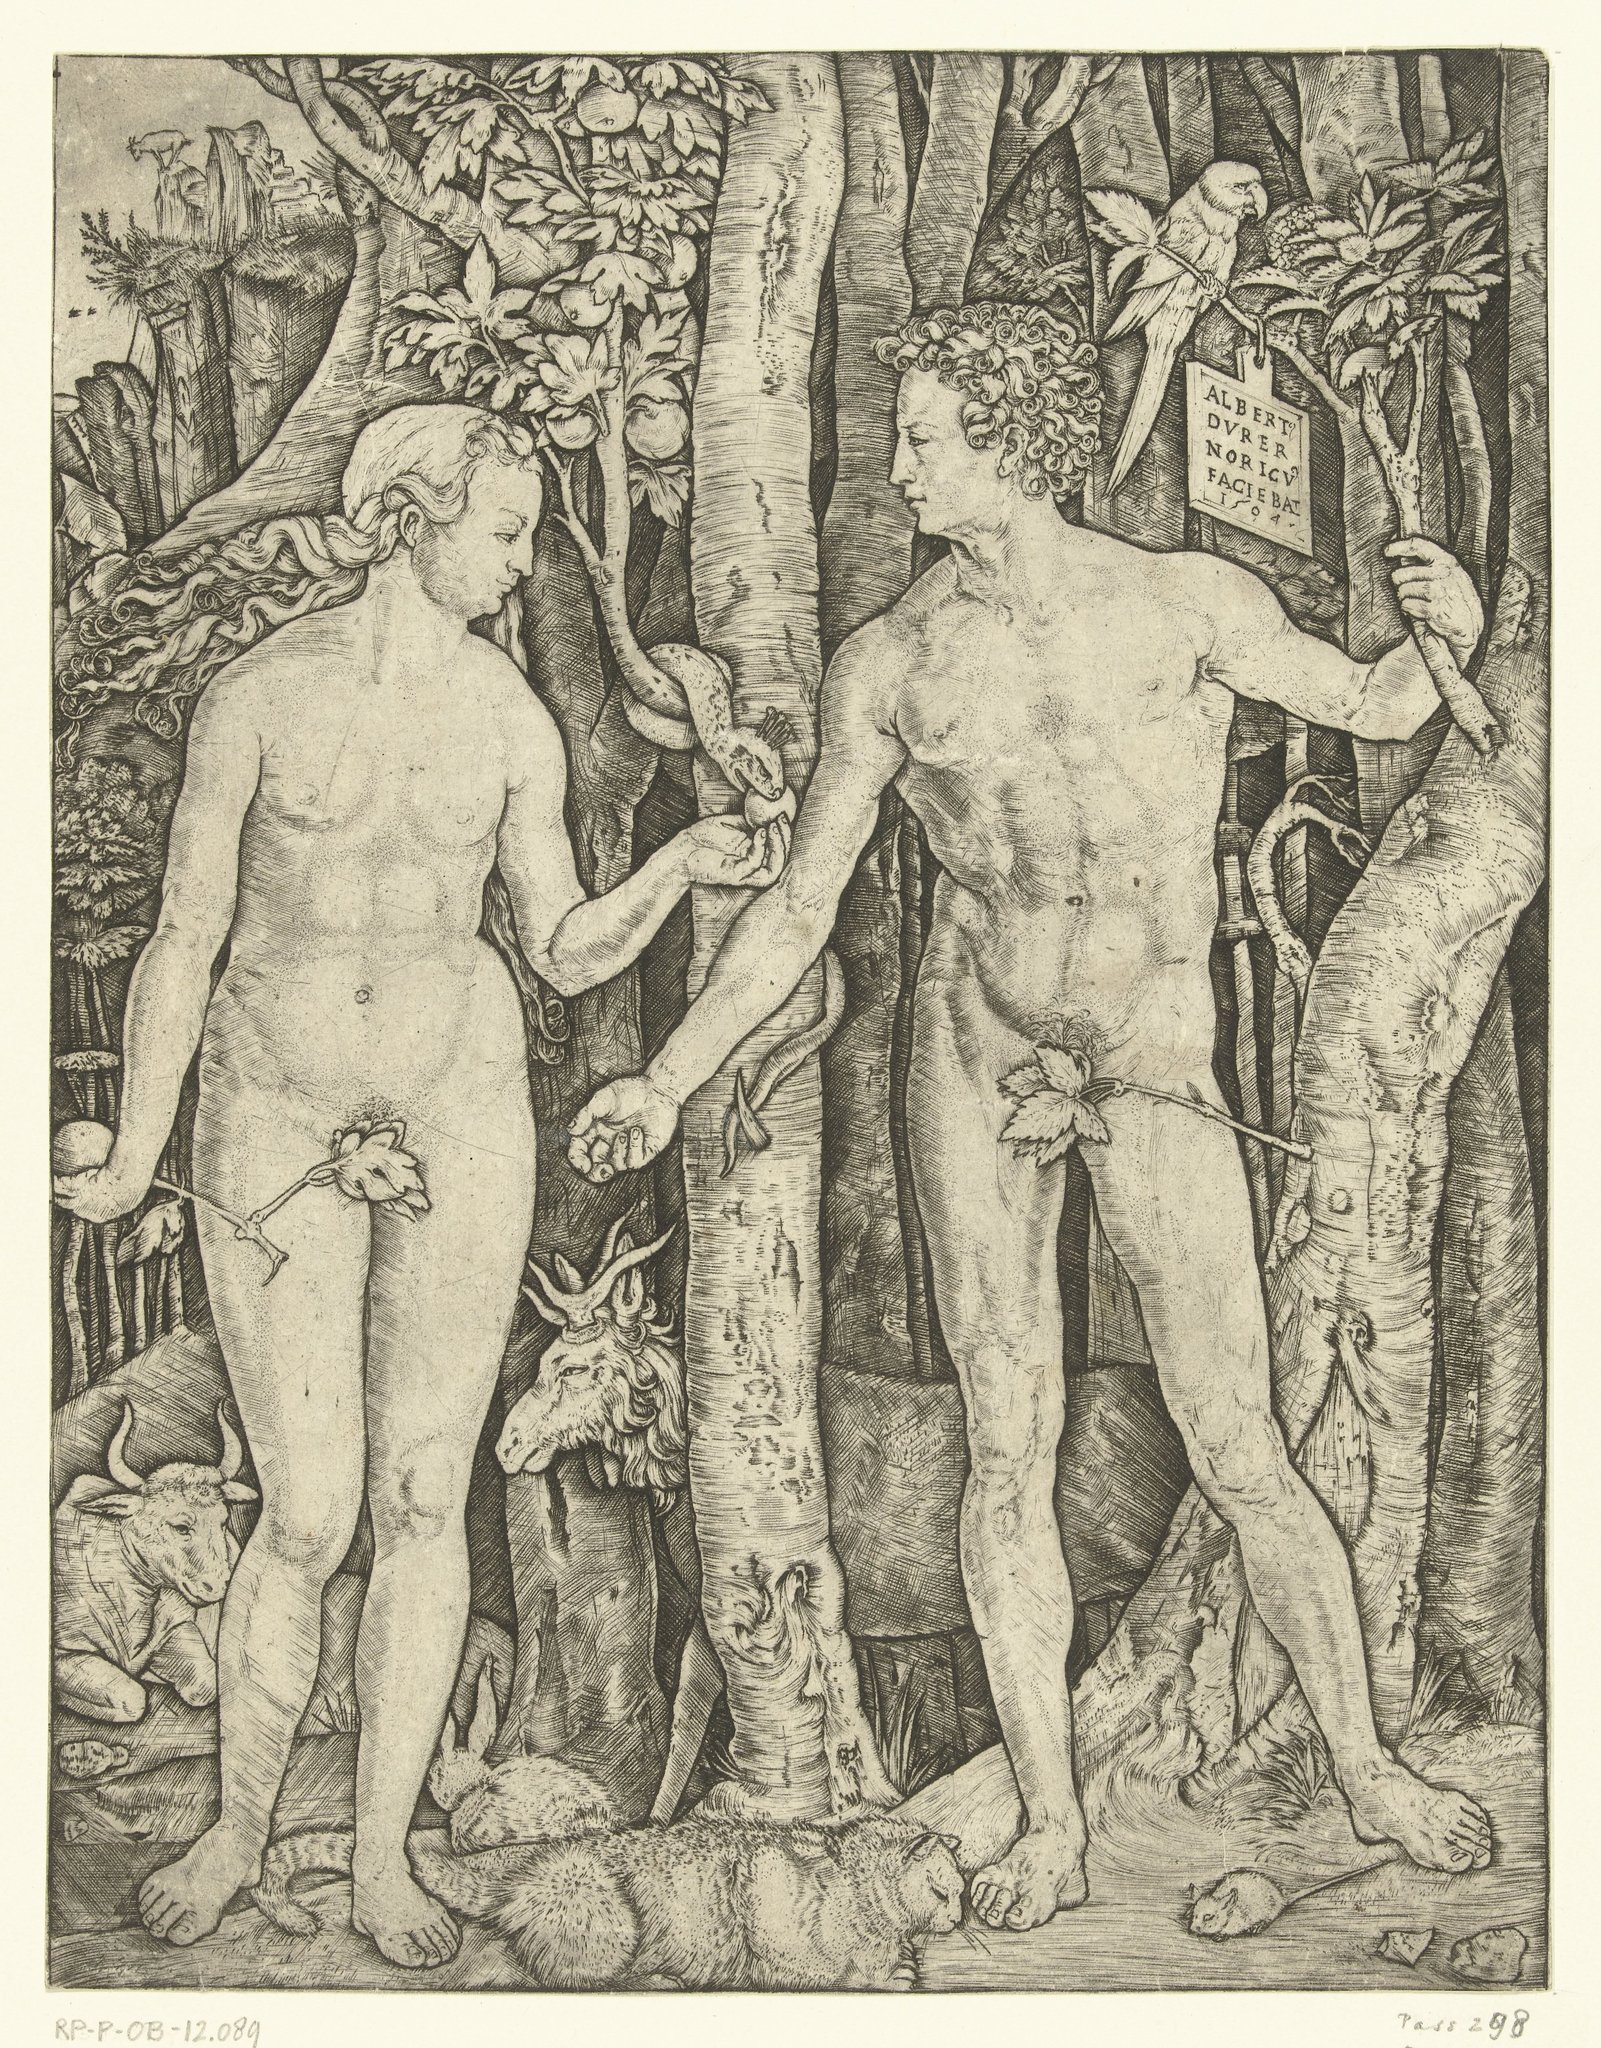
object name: print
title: Adam en Eva bij boom van kennis van goed en kwaad in paradijs tijdens zondeval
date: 1504-1536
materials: paper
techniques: engraving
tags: temptation and fall (scenes with both adam and eve)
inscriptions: collector's mark: Lugt 240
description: Kopie in spiegelbeeld naar houtsnede van Albrecht Dürer.